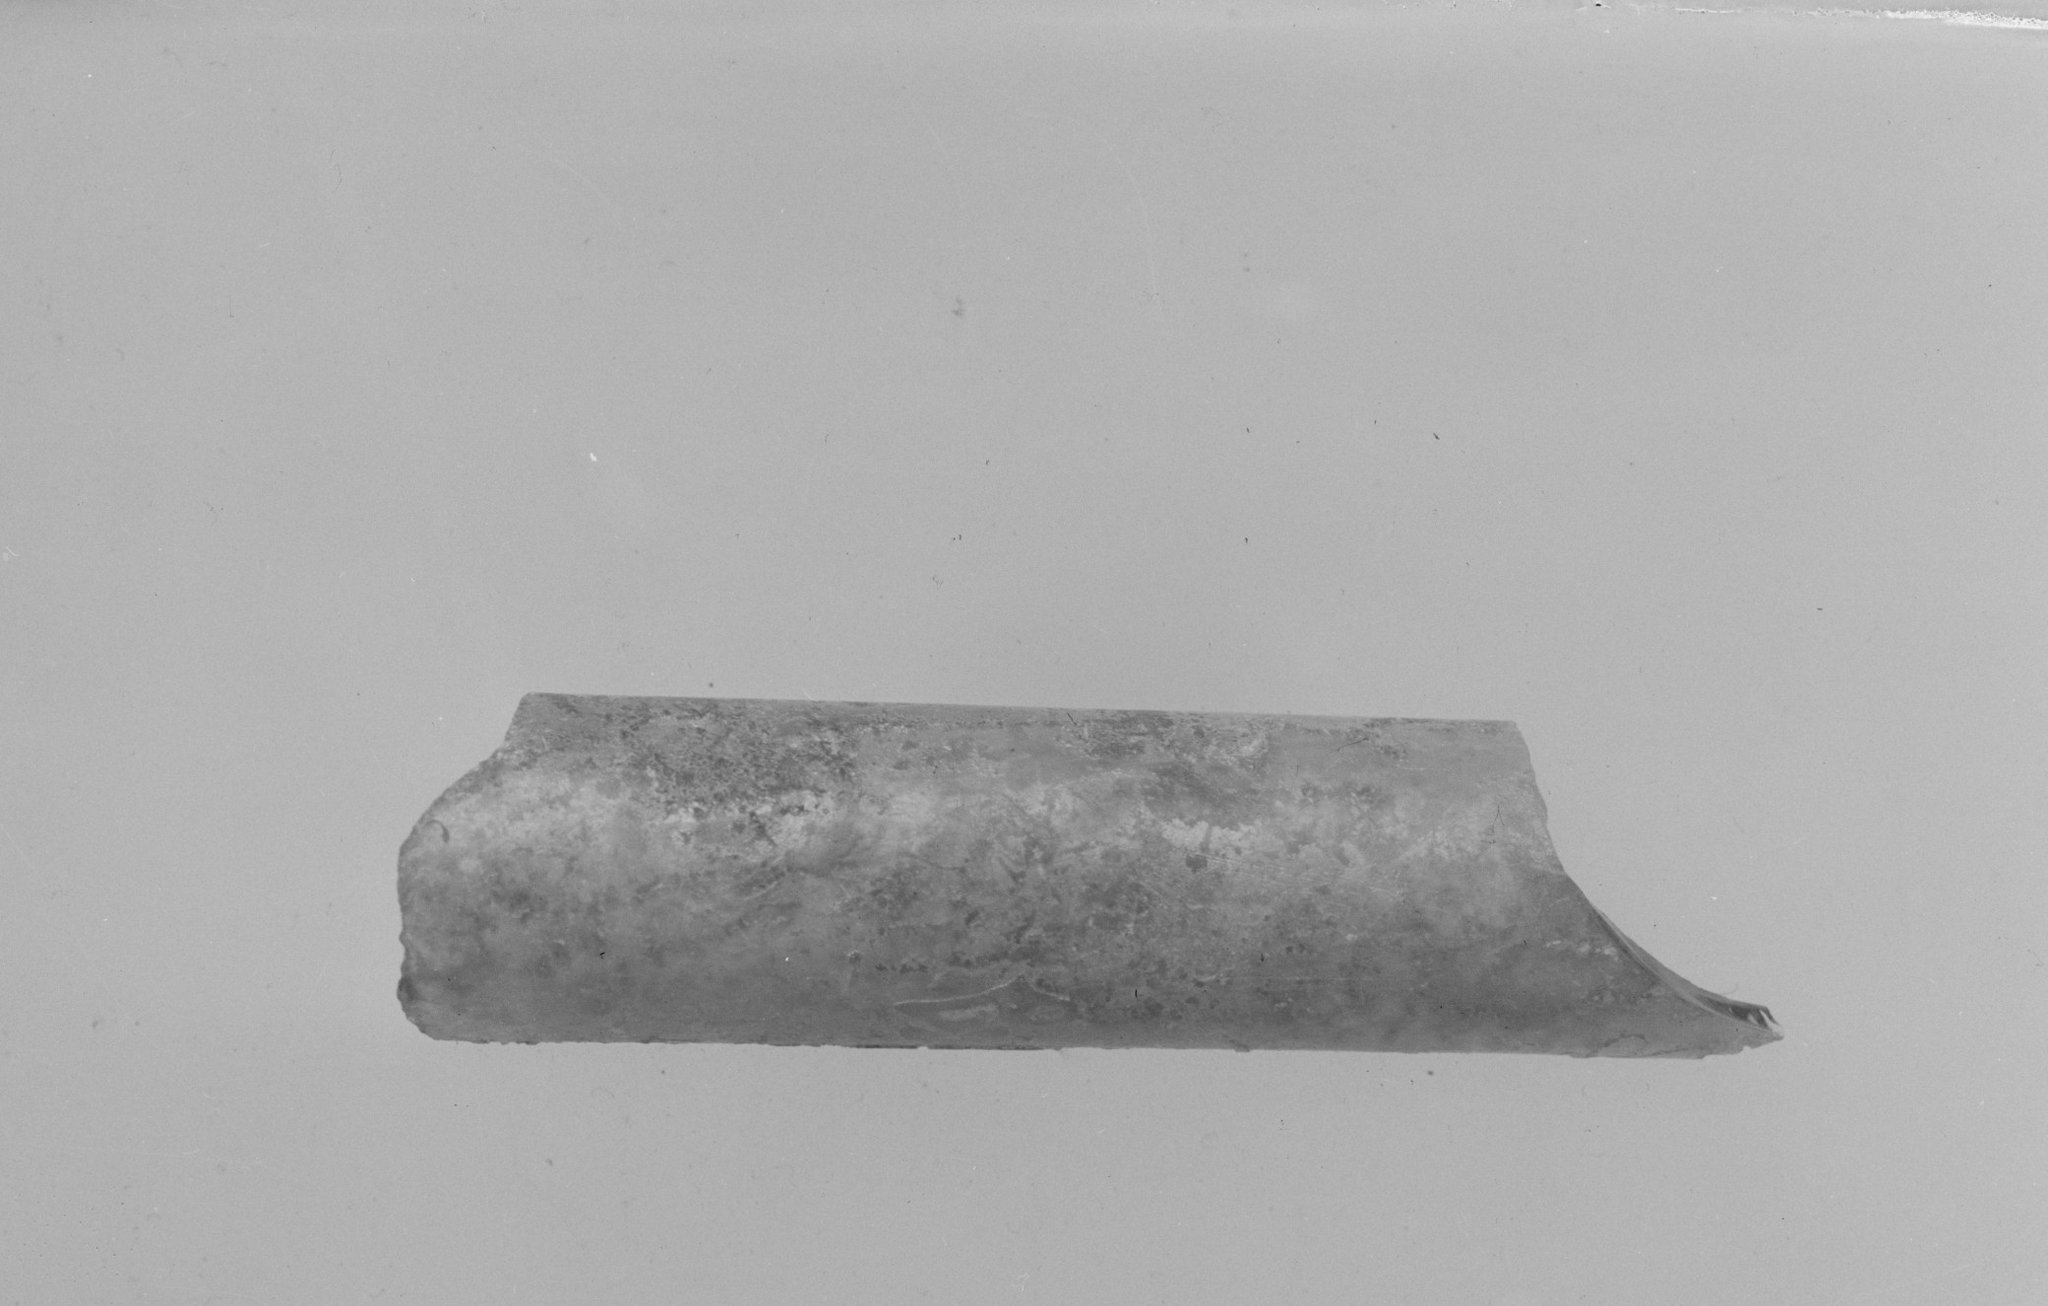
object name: fragment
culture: american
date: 1701-1800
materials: glass, lead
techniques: glassblowing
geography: united states